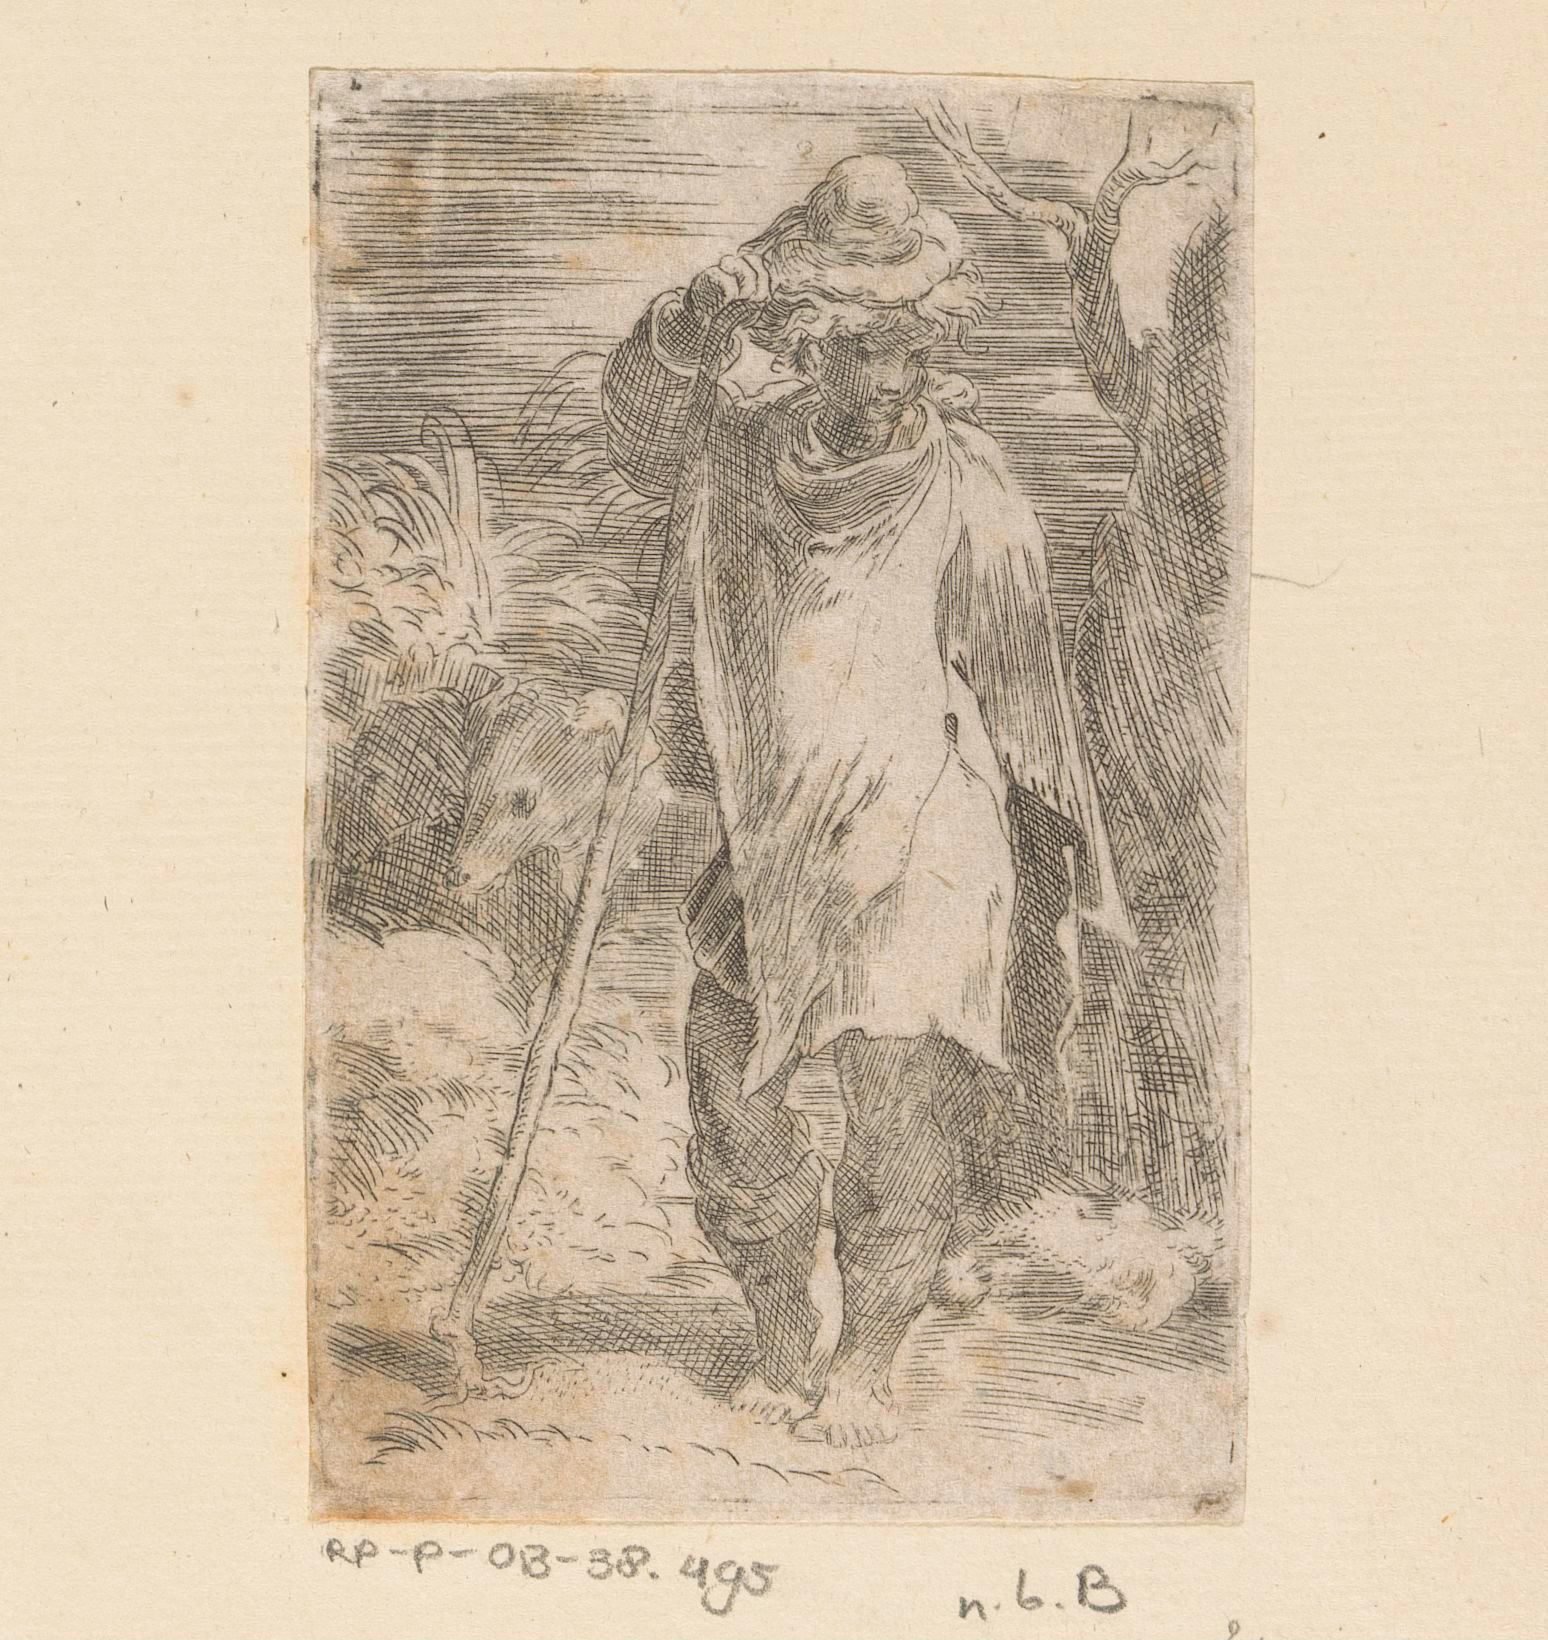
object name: print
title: Jonge herder met stok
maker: Anonymous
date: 1500-1599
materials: paper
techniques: etching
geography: italy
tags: herding, herdsman, herdswoman, shepherd, shepherdess, cowherd, etc., walking-stick, staff, youth, adolescent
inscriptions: collector's mark: Lugt 240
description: Een jonge herder met een stok, een hoed en twee honden in een landschap.